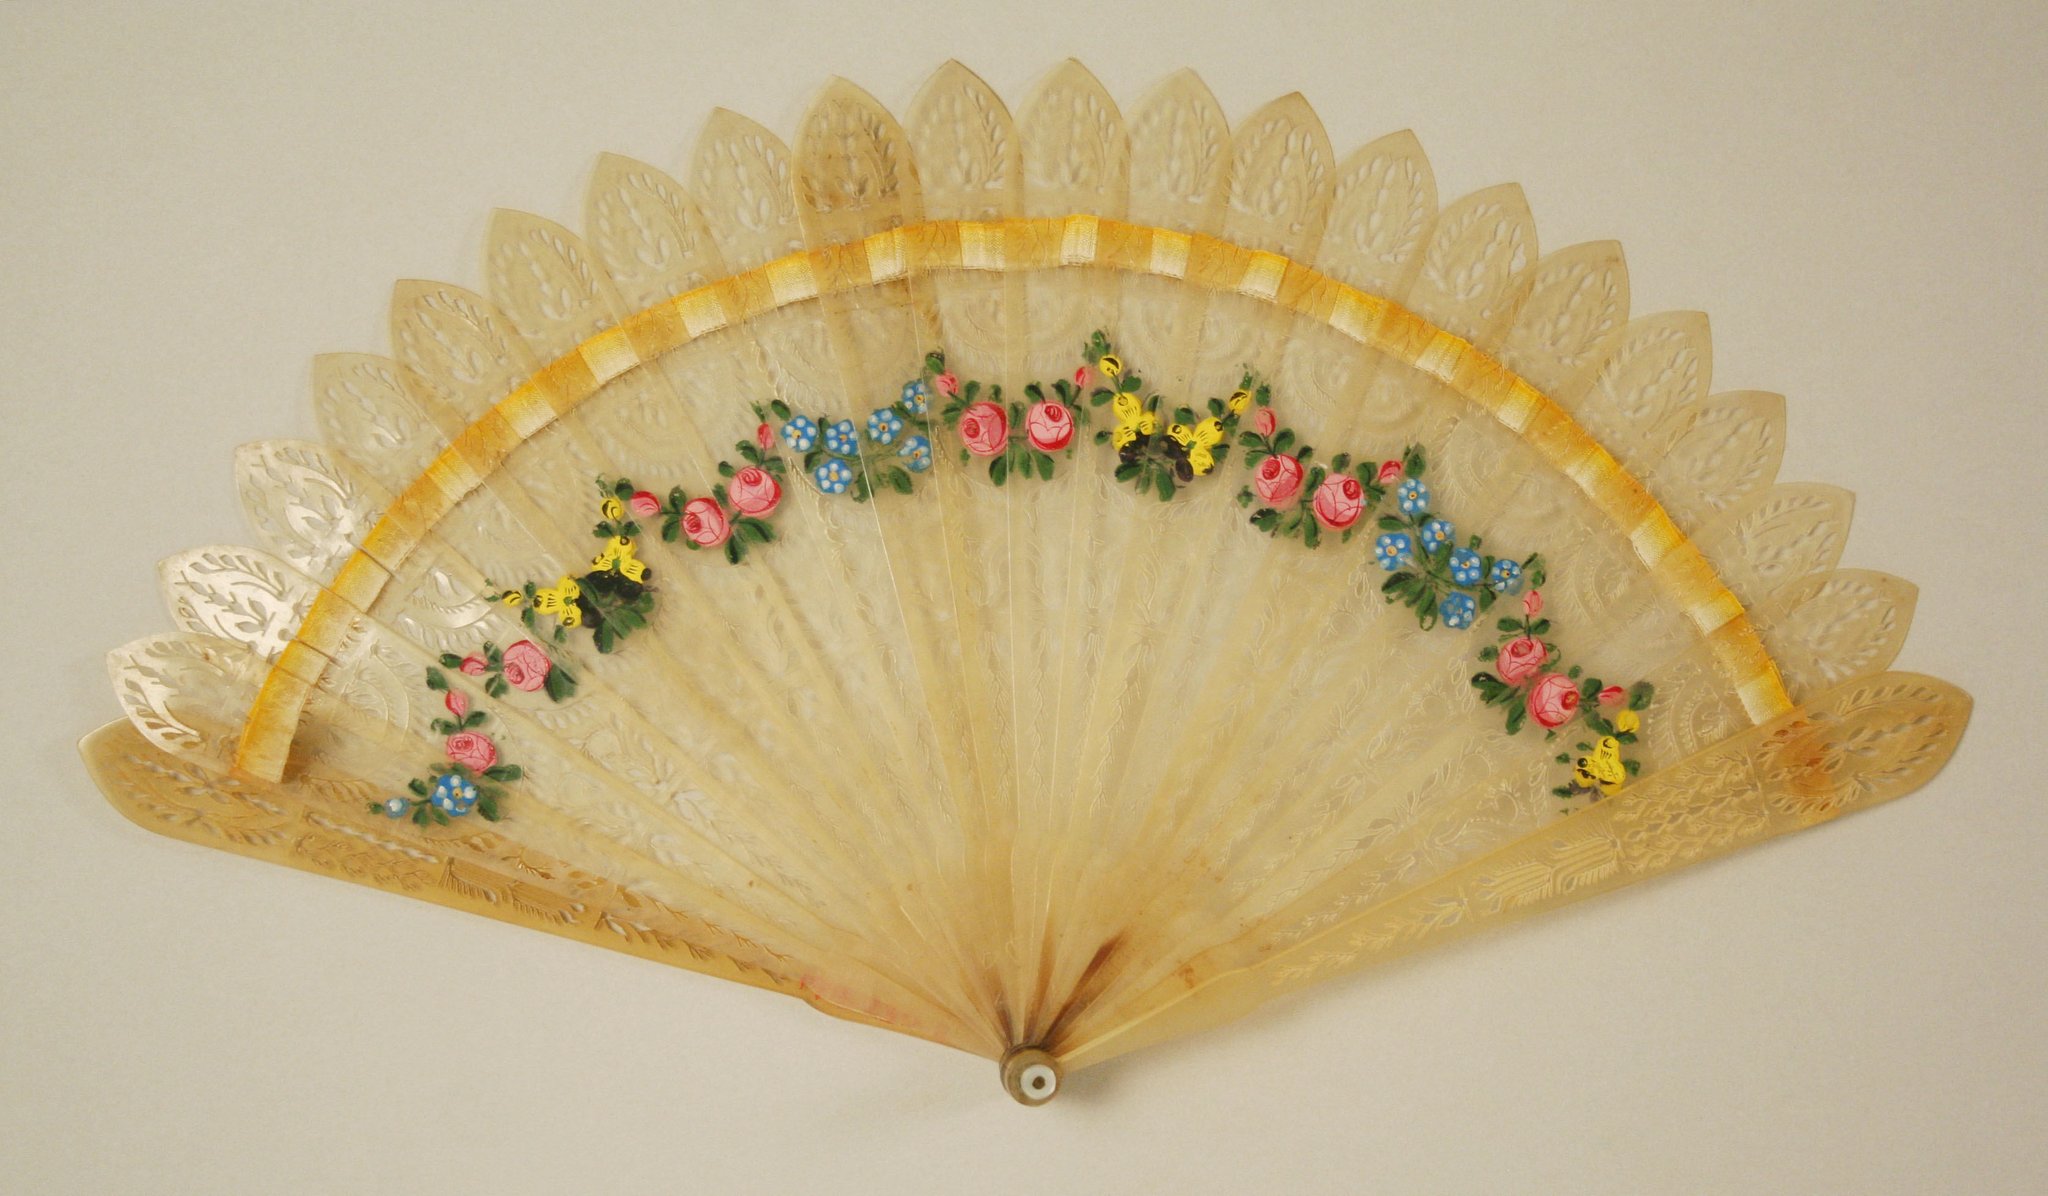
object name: fan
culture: french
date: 1830-1860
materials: horn, silk